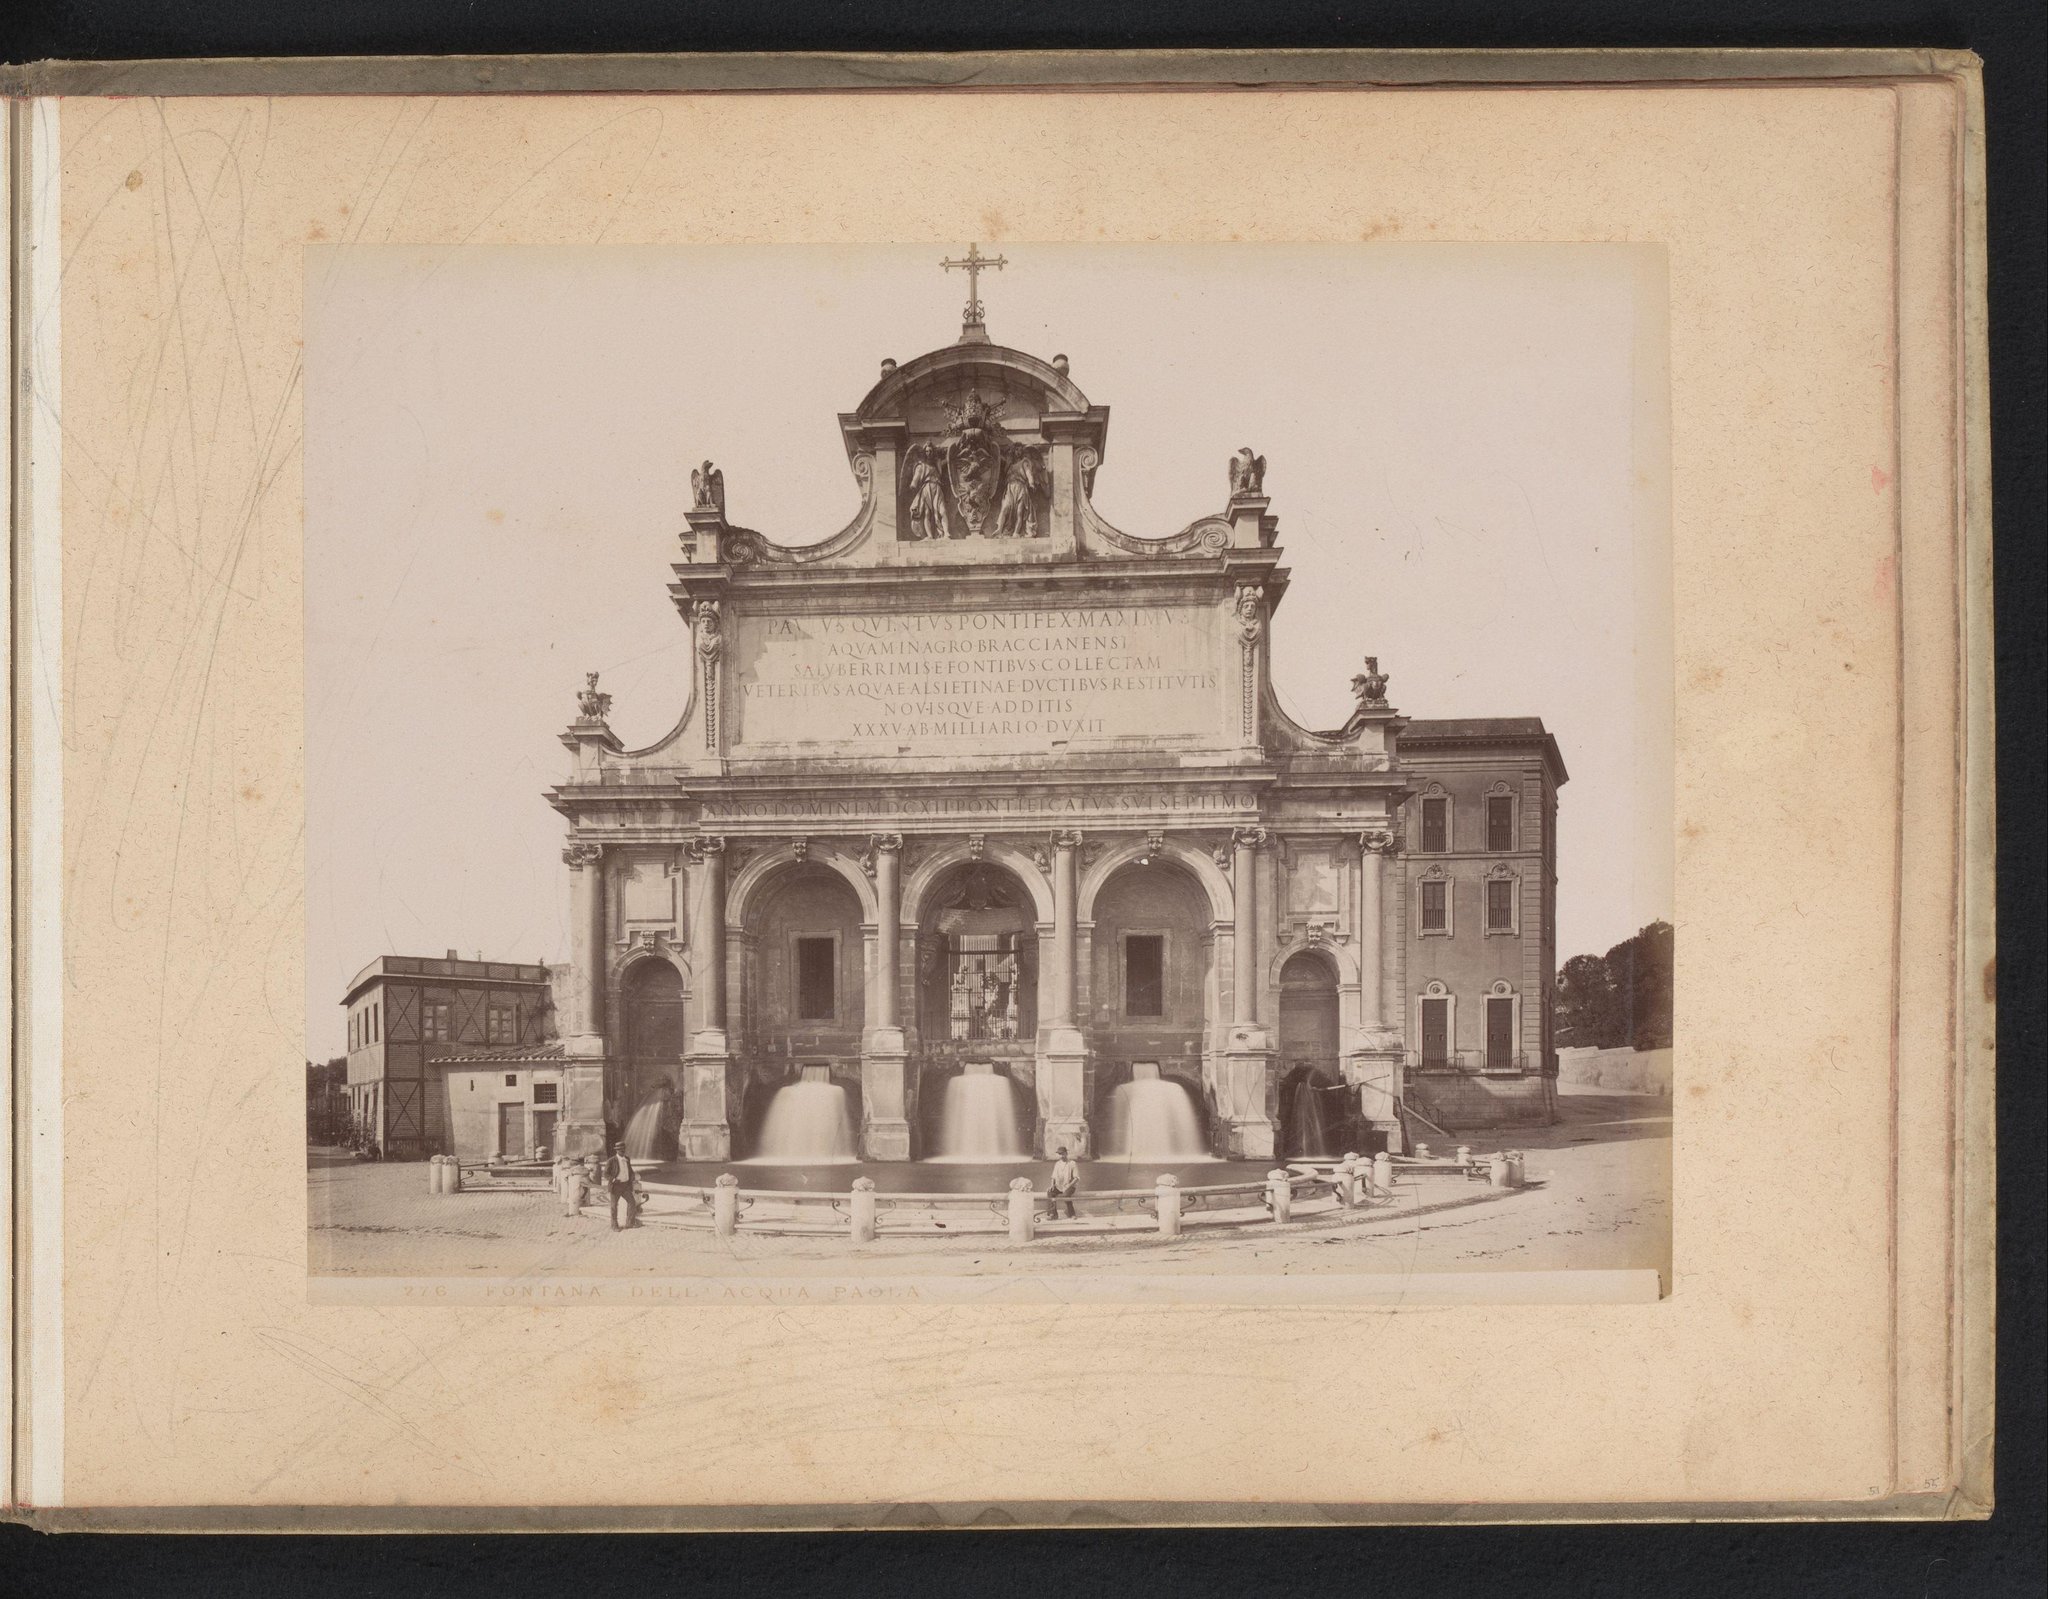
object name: photograph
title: Gezicht op de Fontana dell'Acqua Paolo in Rome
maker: Anonymous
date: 1870-1895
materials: cardboard, photographic support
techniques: albumen print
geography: rome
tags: ornamental fountain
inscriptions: inscription: ‘276 FONTANA DELL' ACQUA PAOLA’